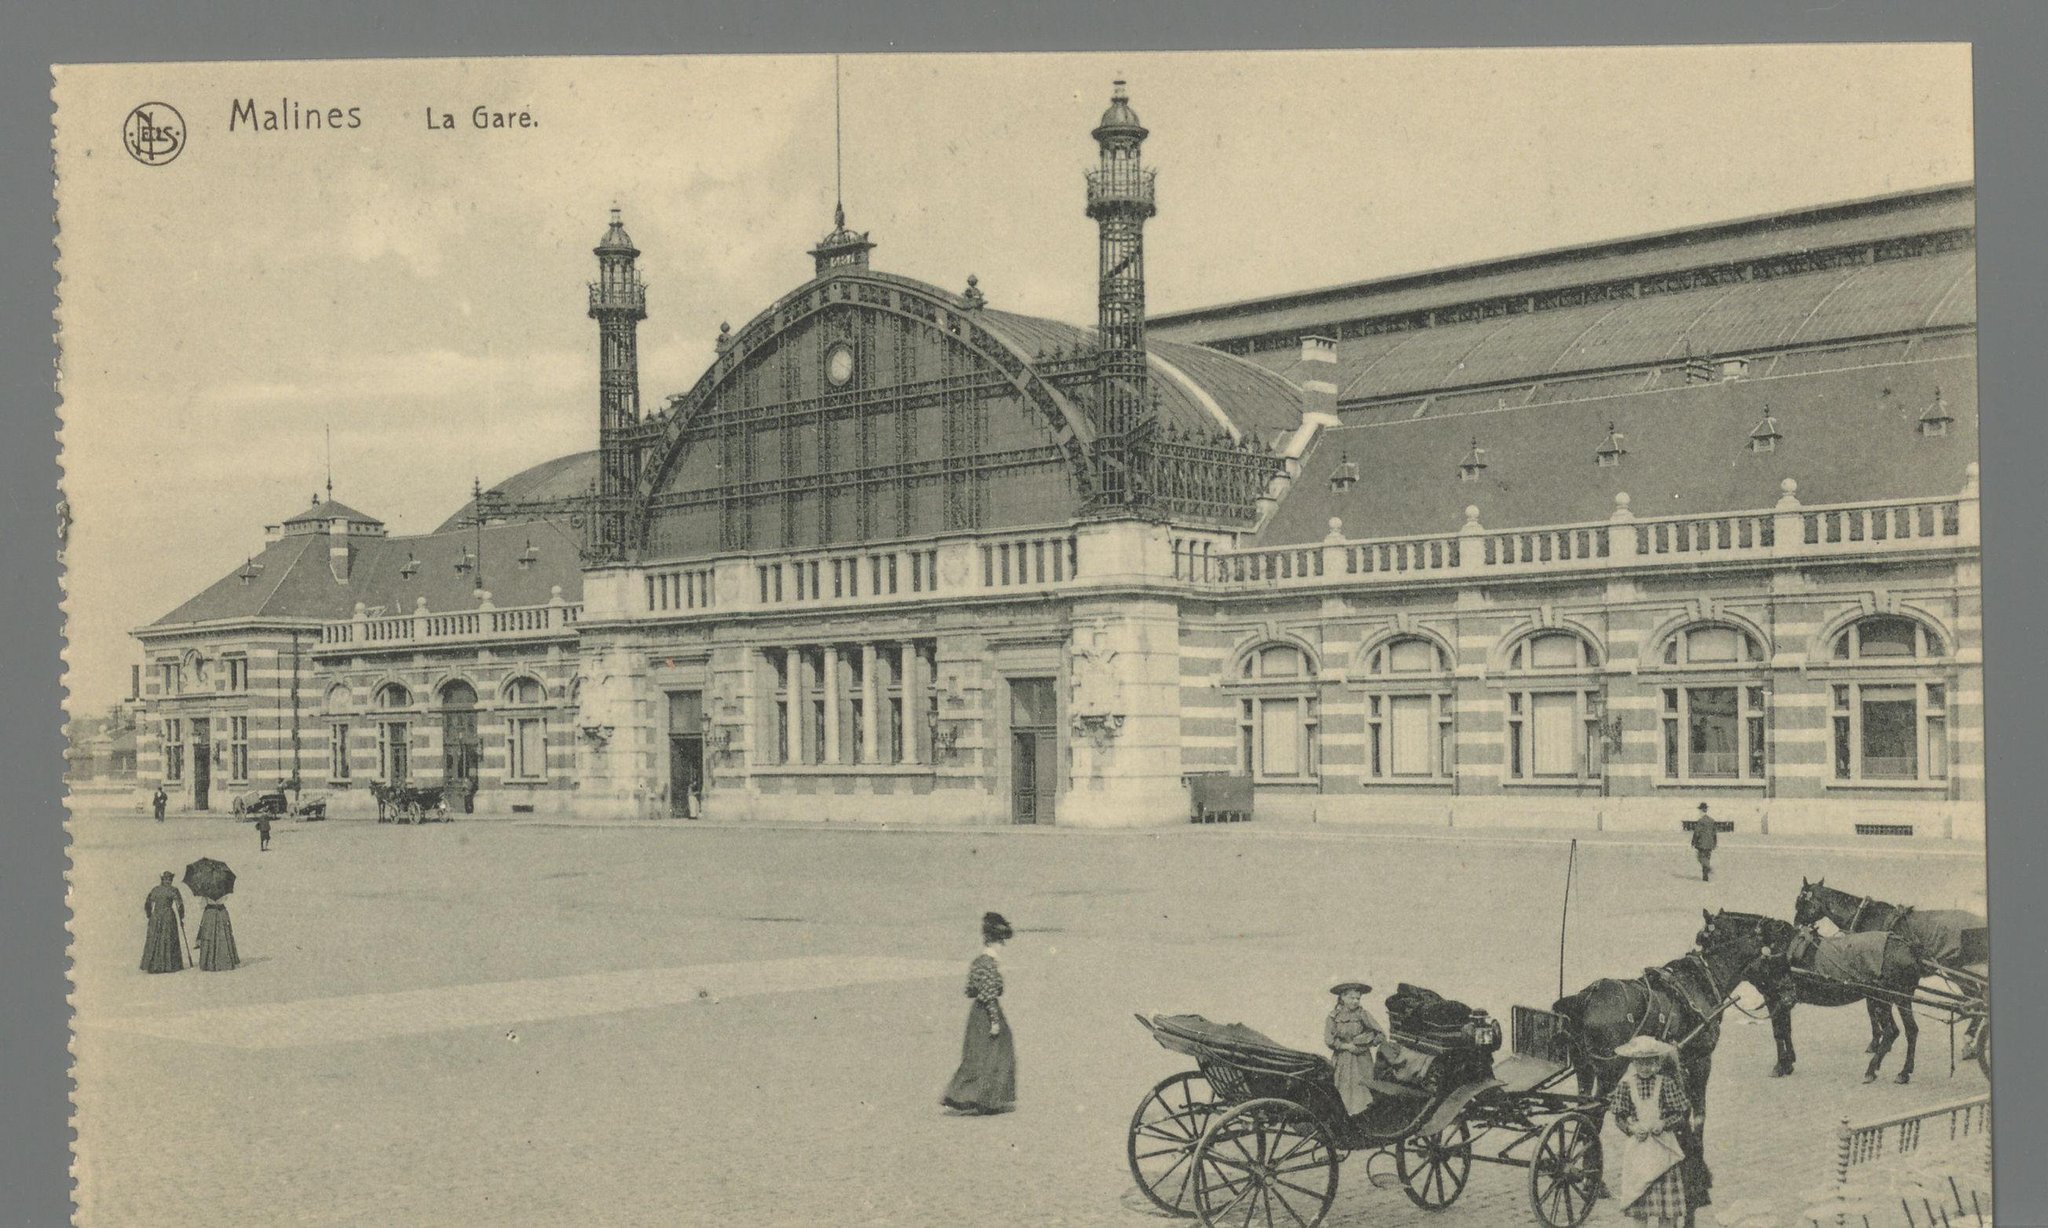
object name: photomechanical print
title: Malines. La Gare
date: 1913-1914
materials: cardboard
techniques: photograph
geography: brussels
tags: four-wheeled, animal-drawn vehicle, e.g.: cab, carriage, coach, station; shelter (railway, tramway), square, place, circus, etc. (+ city(-scape) with figures, staffage), mechelen